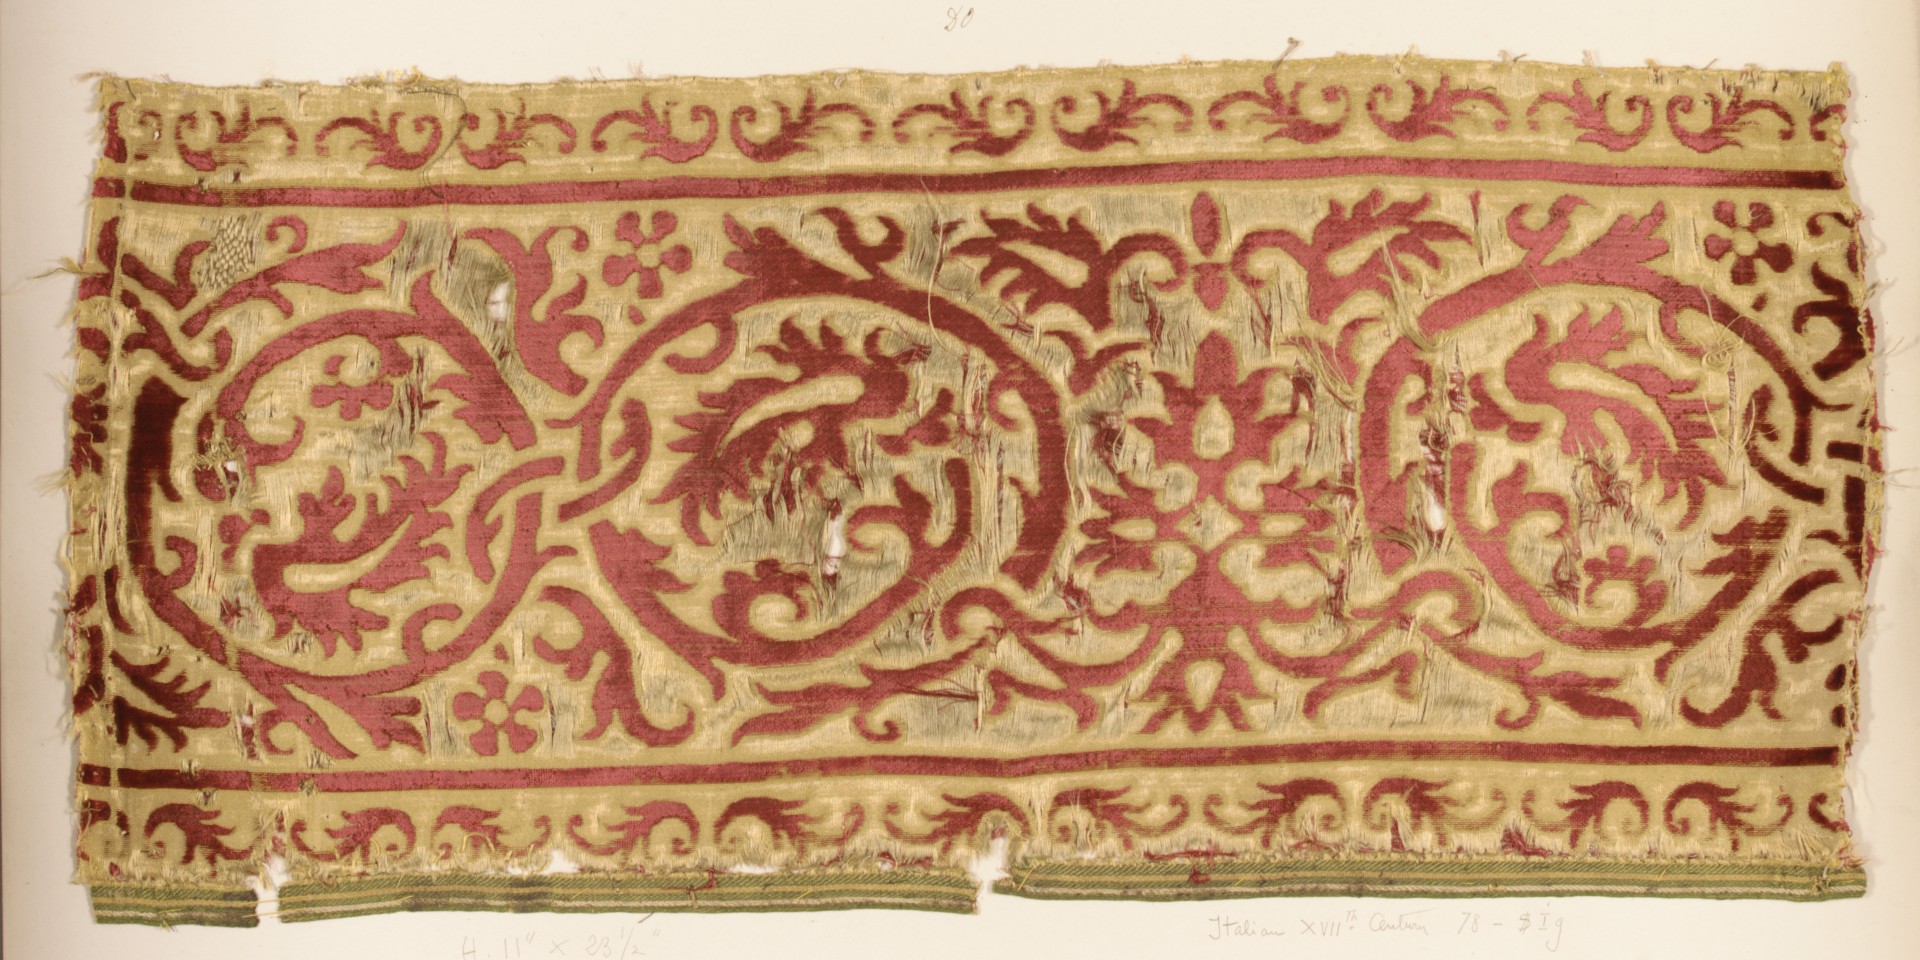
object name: fragment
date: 1601-1700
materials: silk